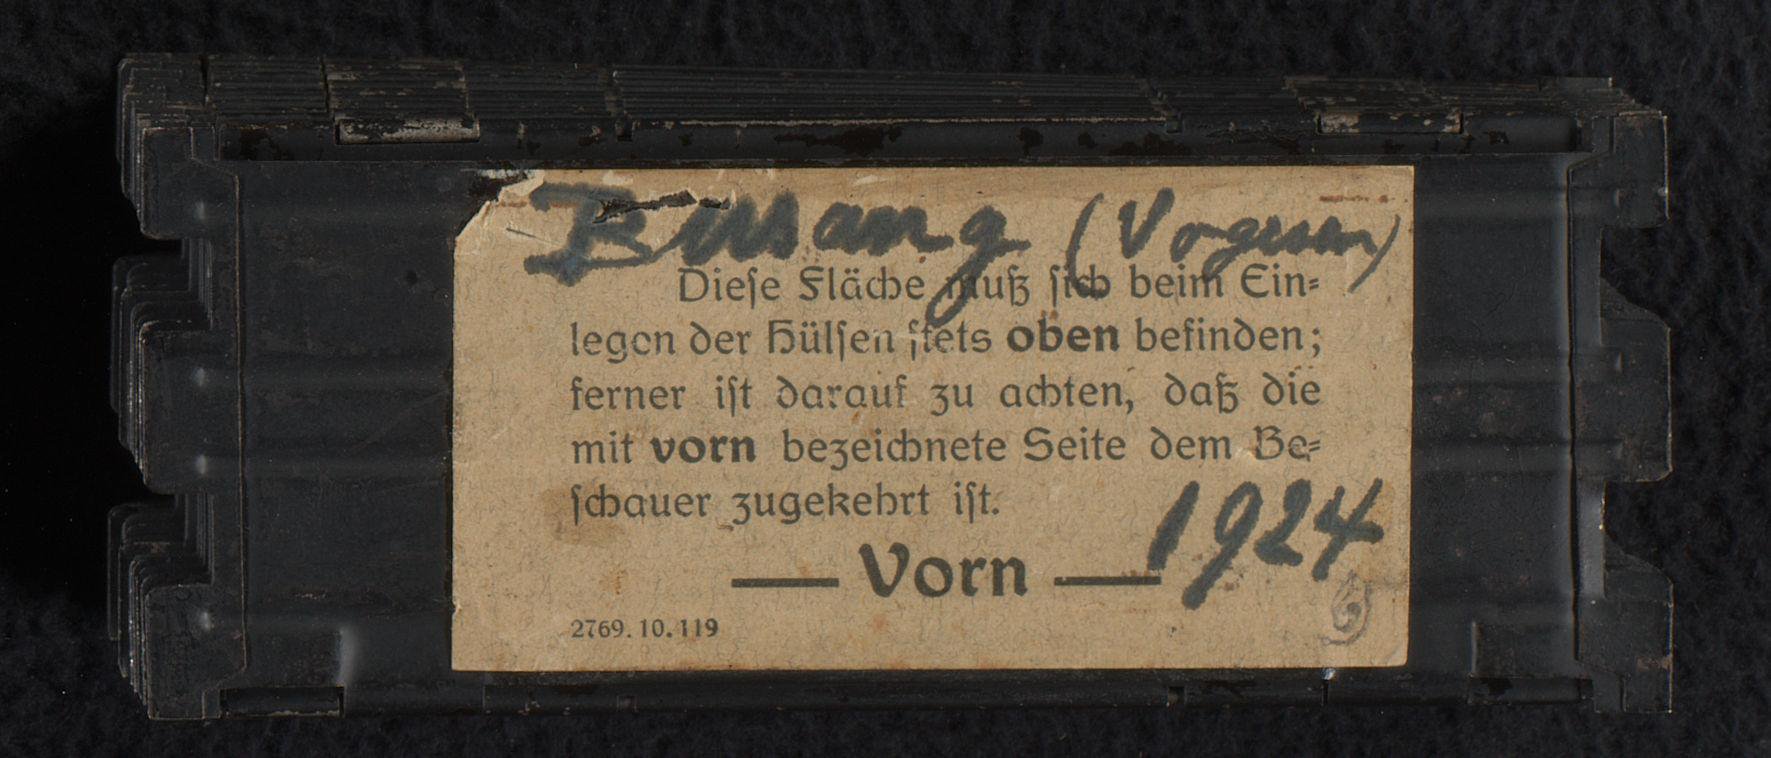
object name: accordion book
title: Leporelloalbum met twaalf stereoglasdia's van diverse plaatsen in Frankrijk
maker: Anonymous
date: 1924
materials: glass, metal, paper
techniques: slide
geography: france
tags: landscapes in the temperate zone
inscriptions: inscription: ‘Diese Fläche muß sich beim Ein-/ (...) -Vorn-/ 2769.10.119’, inscription: ‘Busang (Vogesen)/ 1924’